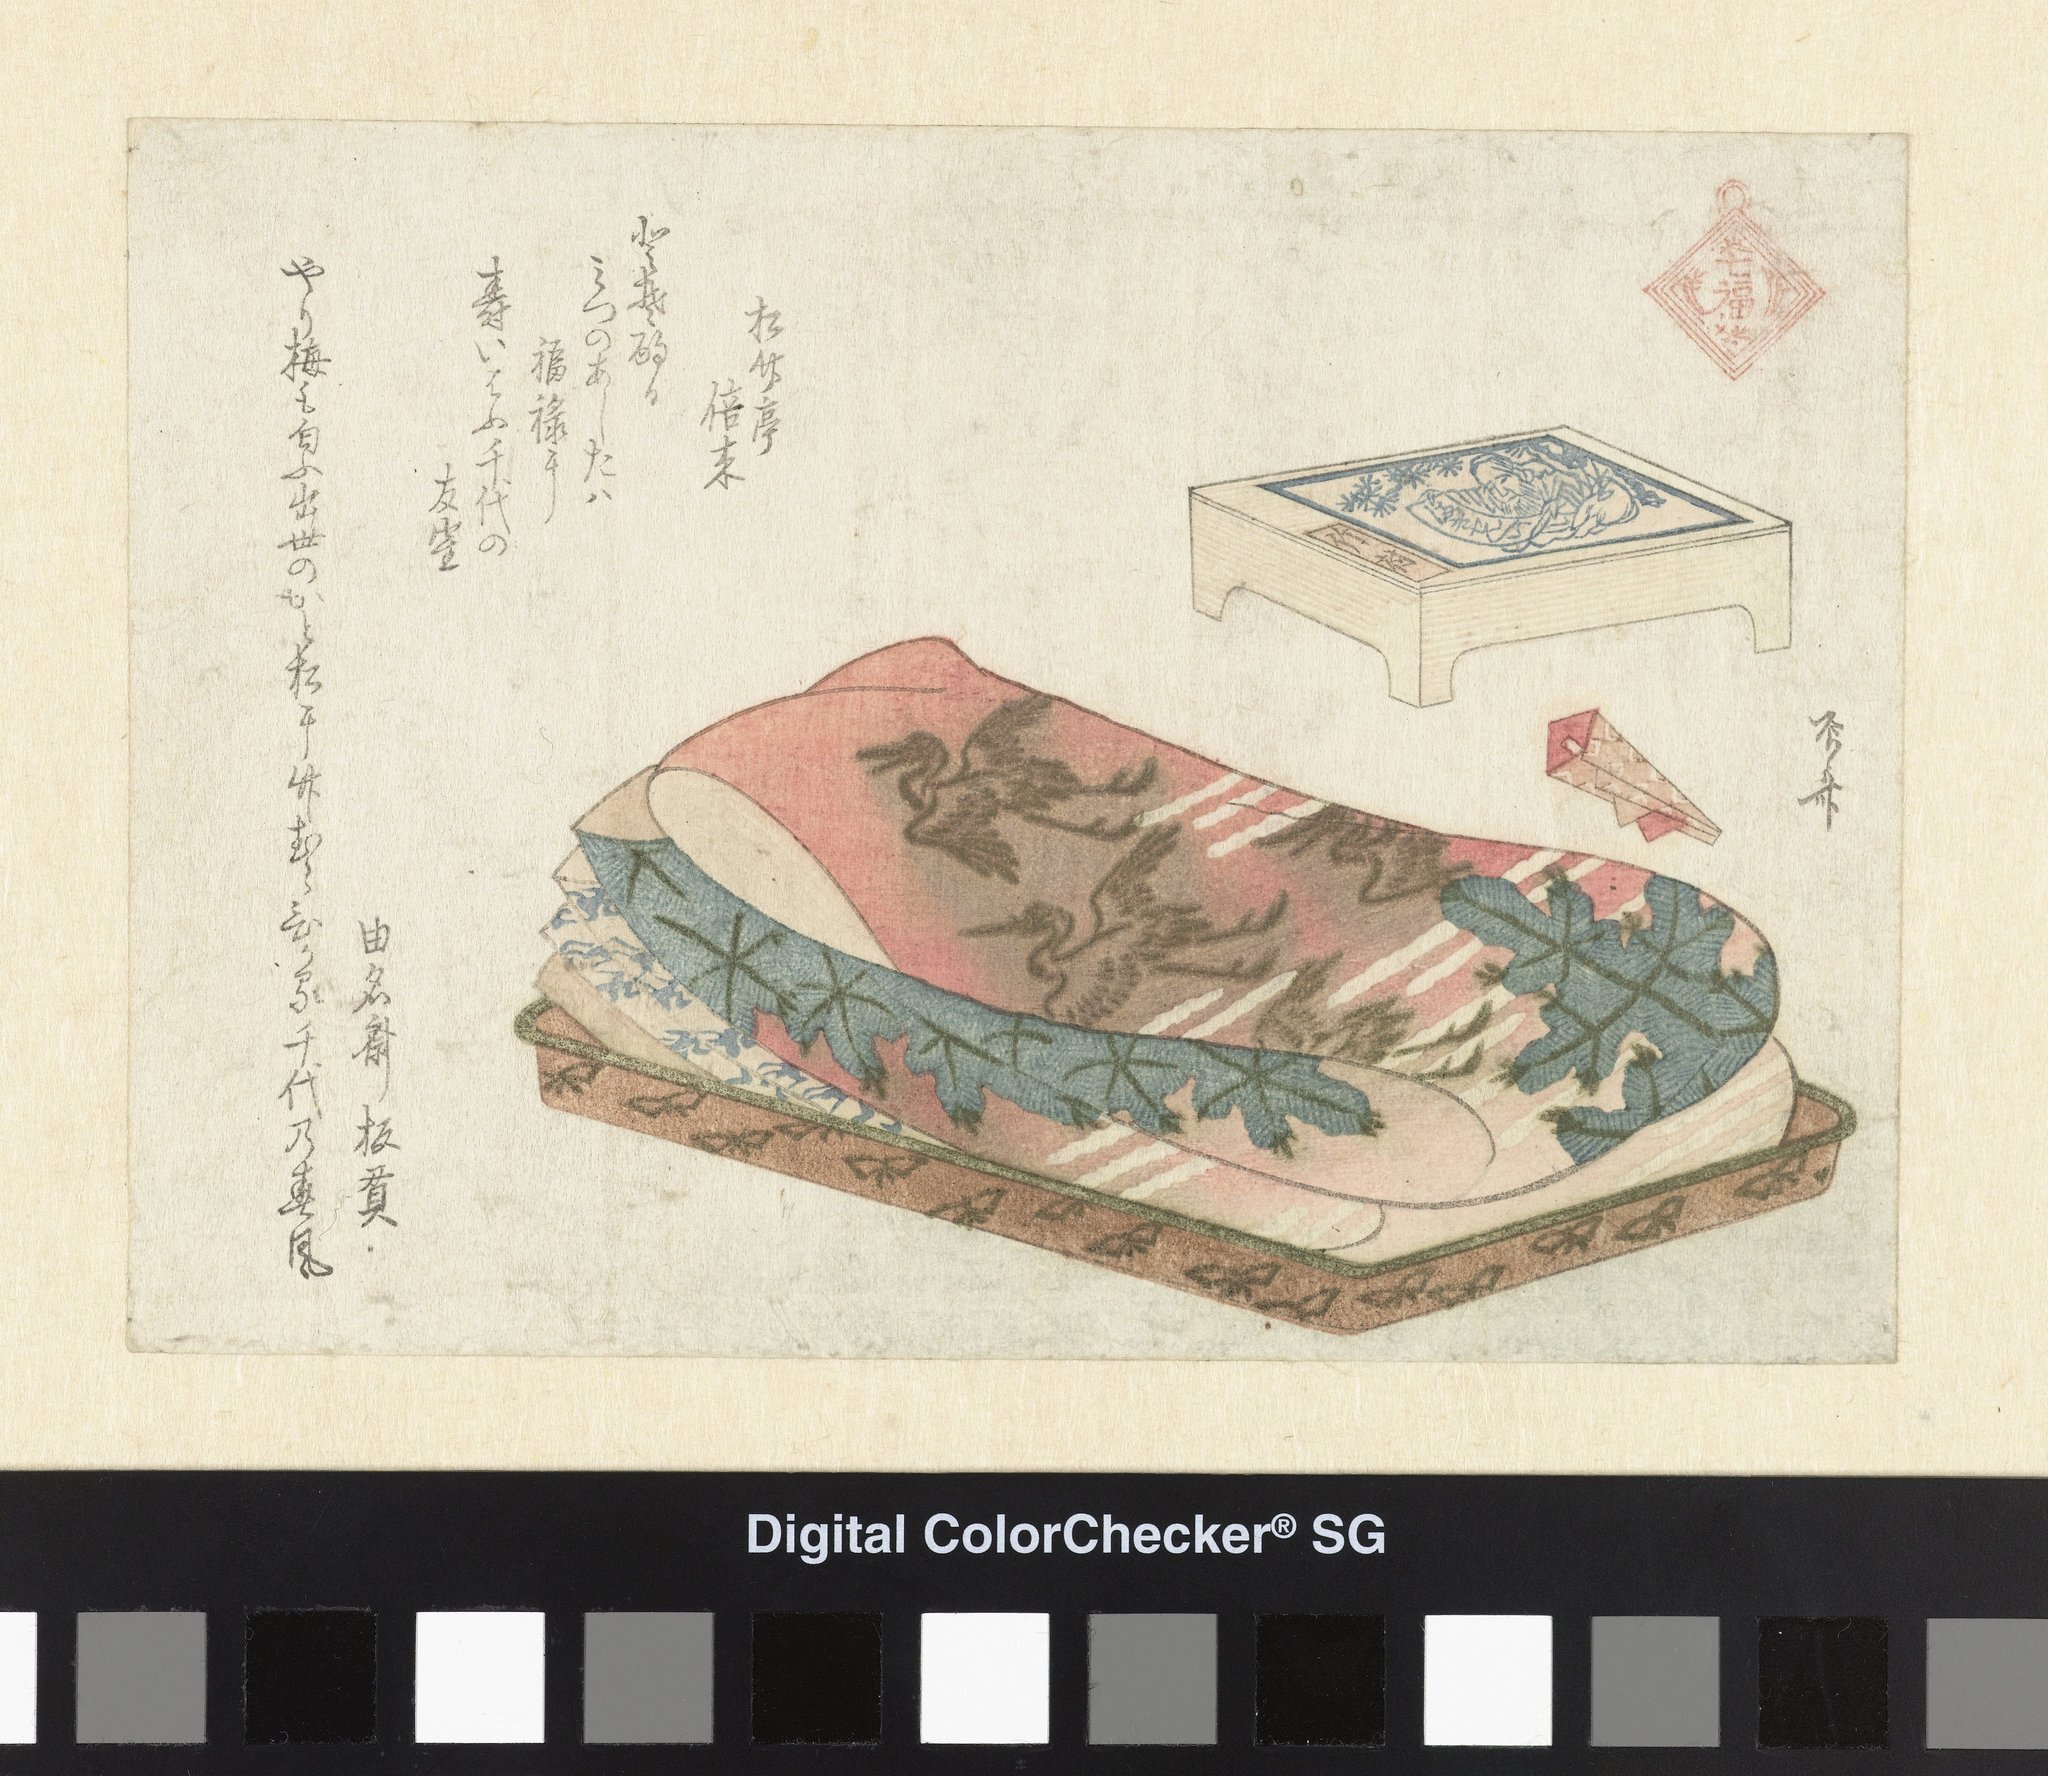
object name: surimono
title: De zeven geluksgoden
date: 1800-1805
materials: paper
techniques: blind stamped, woodcut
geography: japan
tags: clothes covering the entire body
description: Een surimono is een luxe uitgevoerde prent waarop beeld met één of meerdere gedichten gecombineerd is. Bij het drukken van een surimono werd vaak gebruik gemaakt van dikker papier, blinddruk en metaal pigmenten, zoals koper- en zilverpoeder. De prenten werden vaak in opdracht van dichters gemaakt en als exclusief geschenk aan vrienden en relaties gegeven.